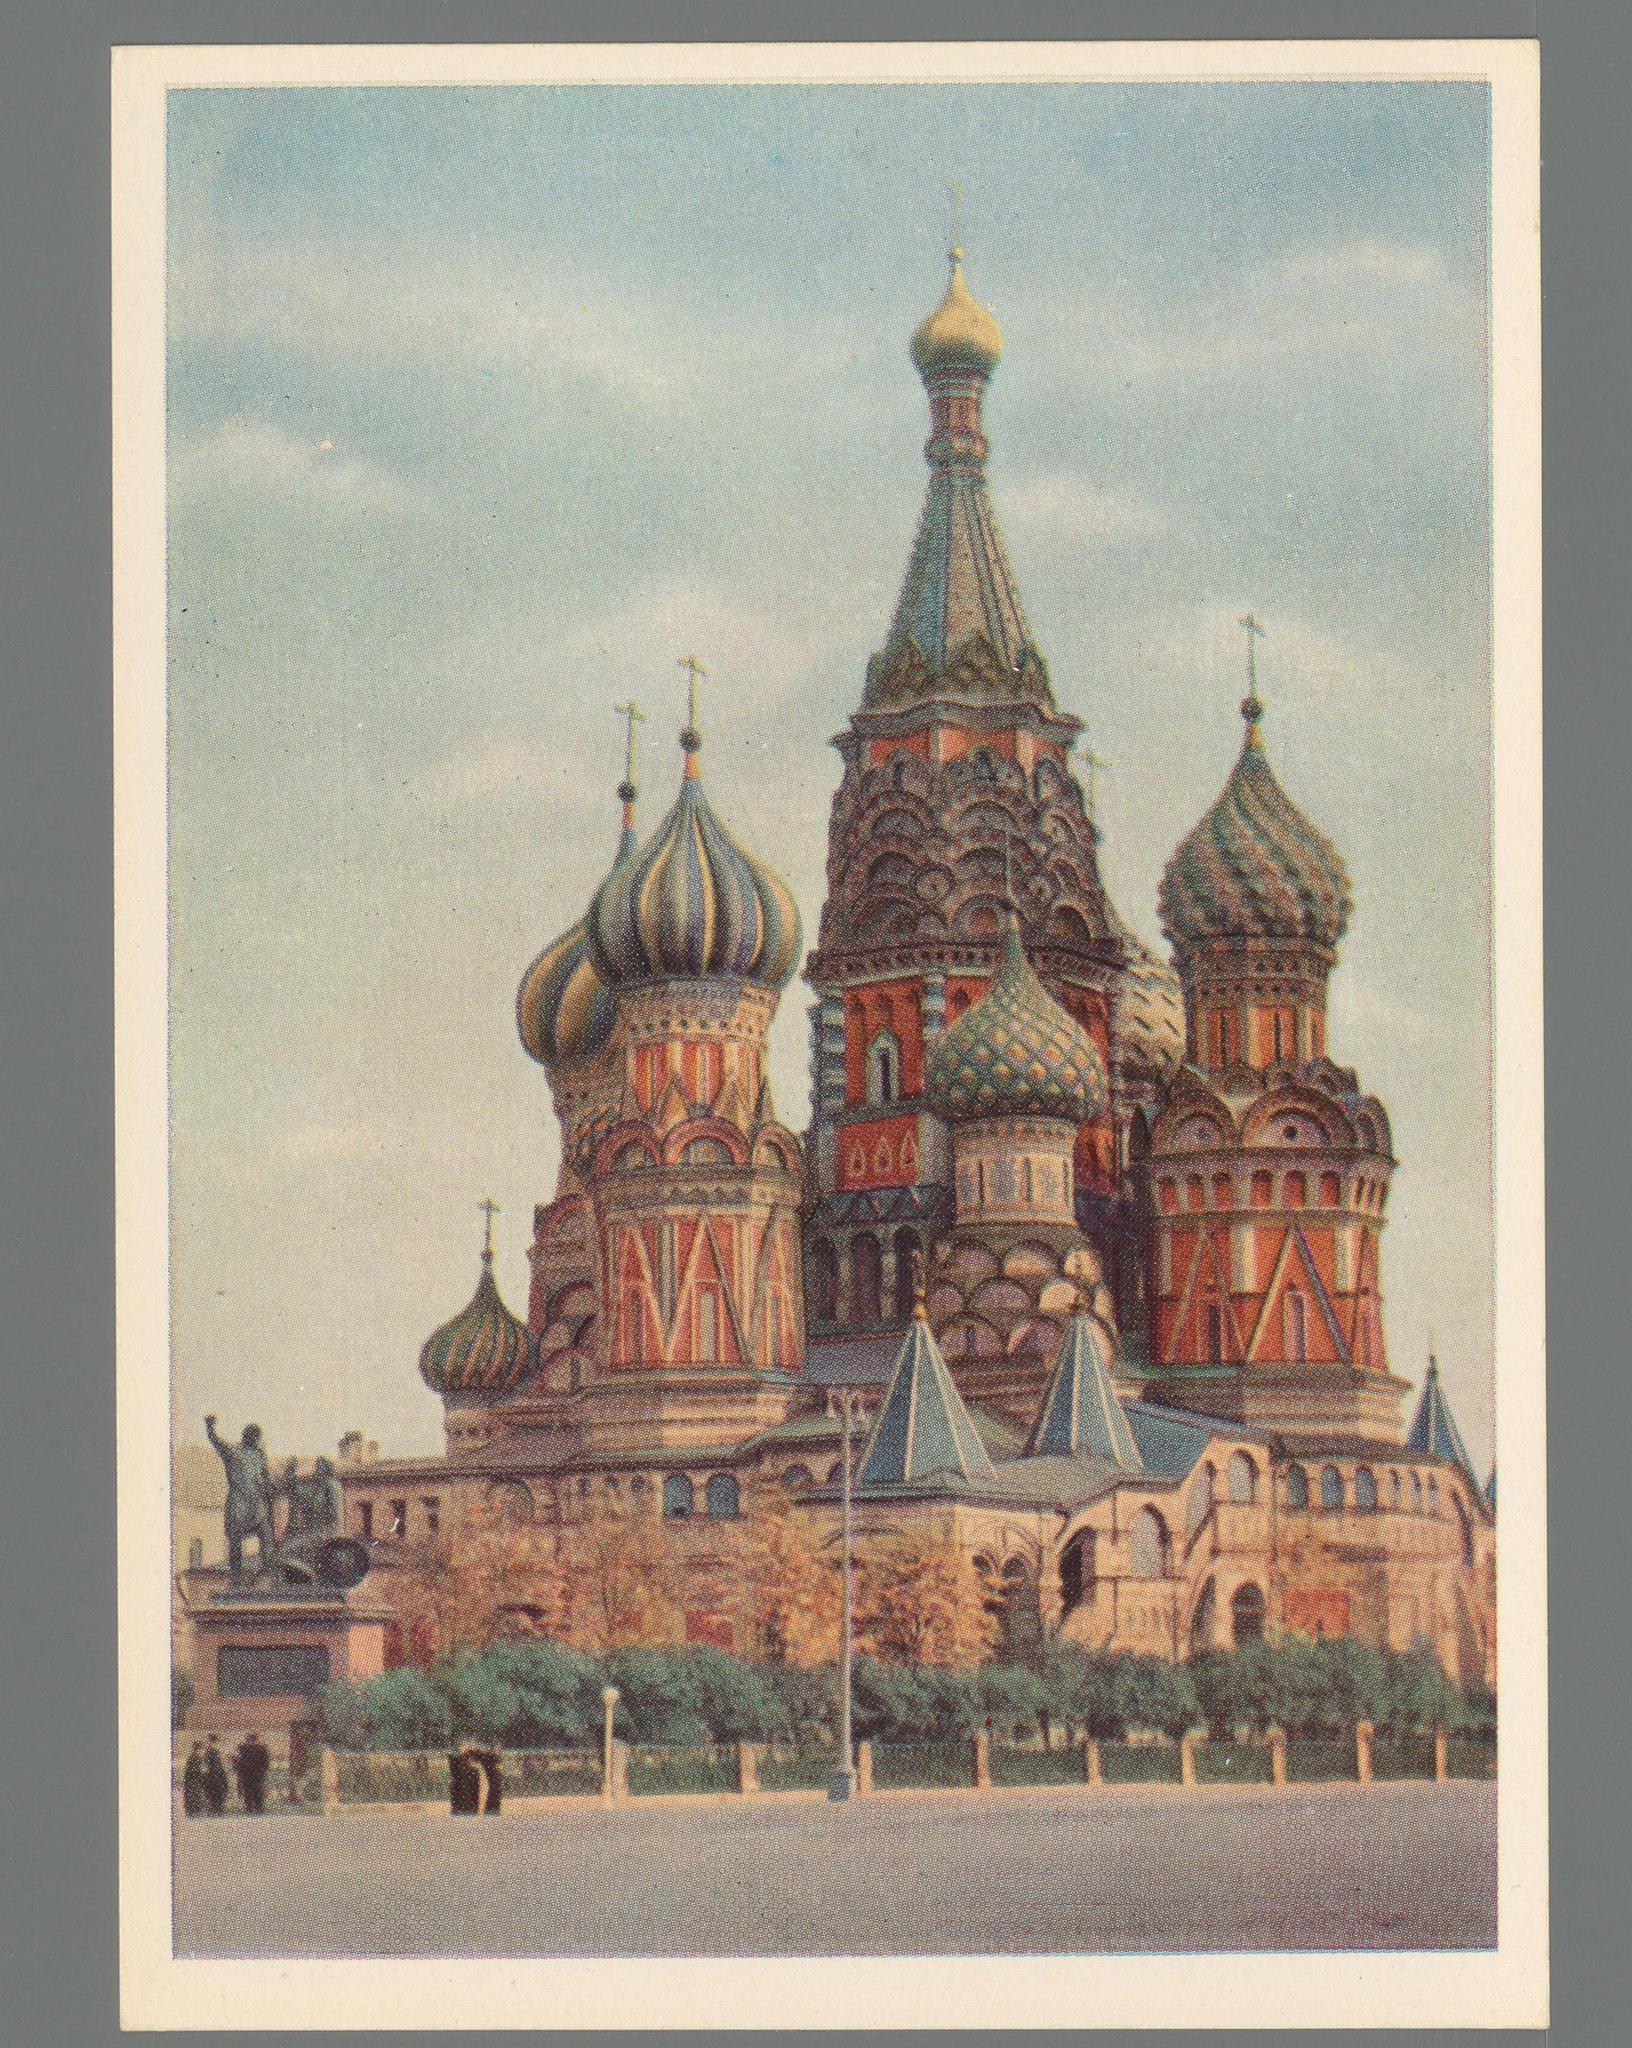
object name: photomechanical print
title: Moscow. St. Basil's Cathedral (XVI c.) / Moskau. Basilius-Kathedrale (16. Jh.) / Moscou. Eglise Basile-le-Bienheureux (XVIe siècle)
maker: Anonymous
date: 1956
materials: cardboard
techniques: color autotype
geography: moscow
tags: church (exterior)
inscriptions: date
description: De titel op object staat ook in het Russisch.